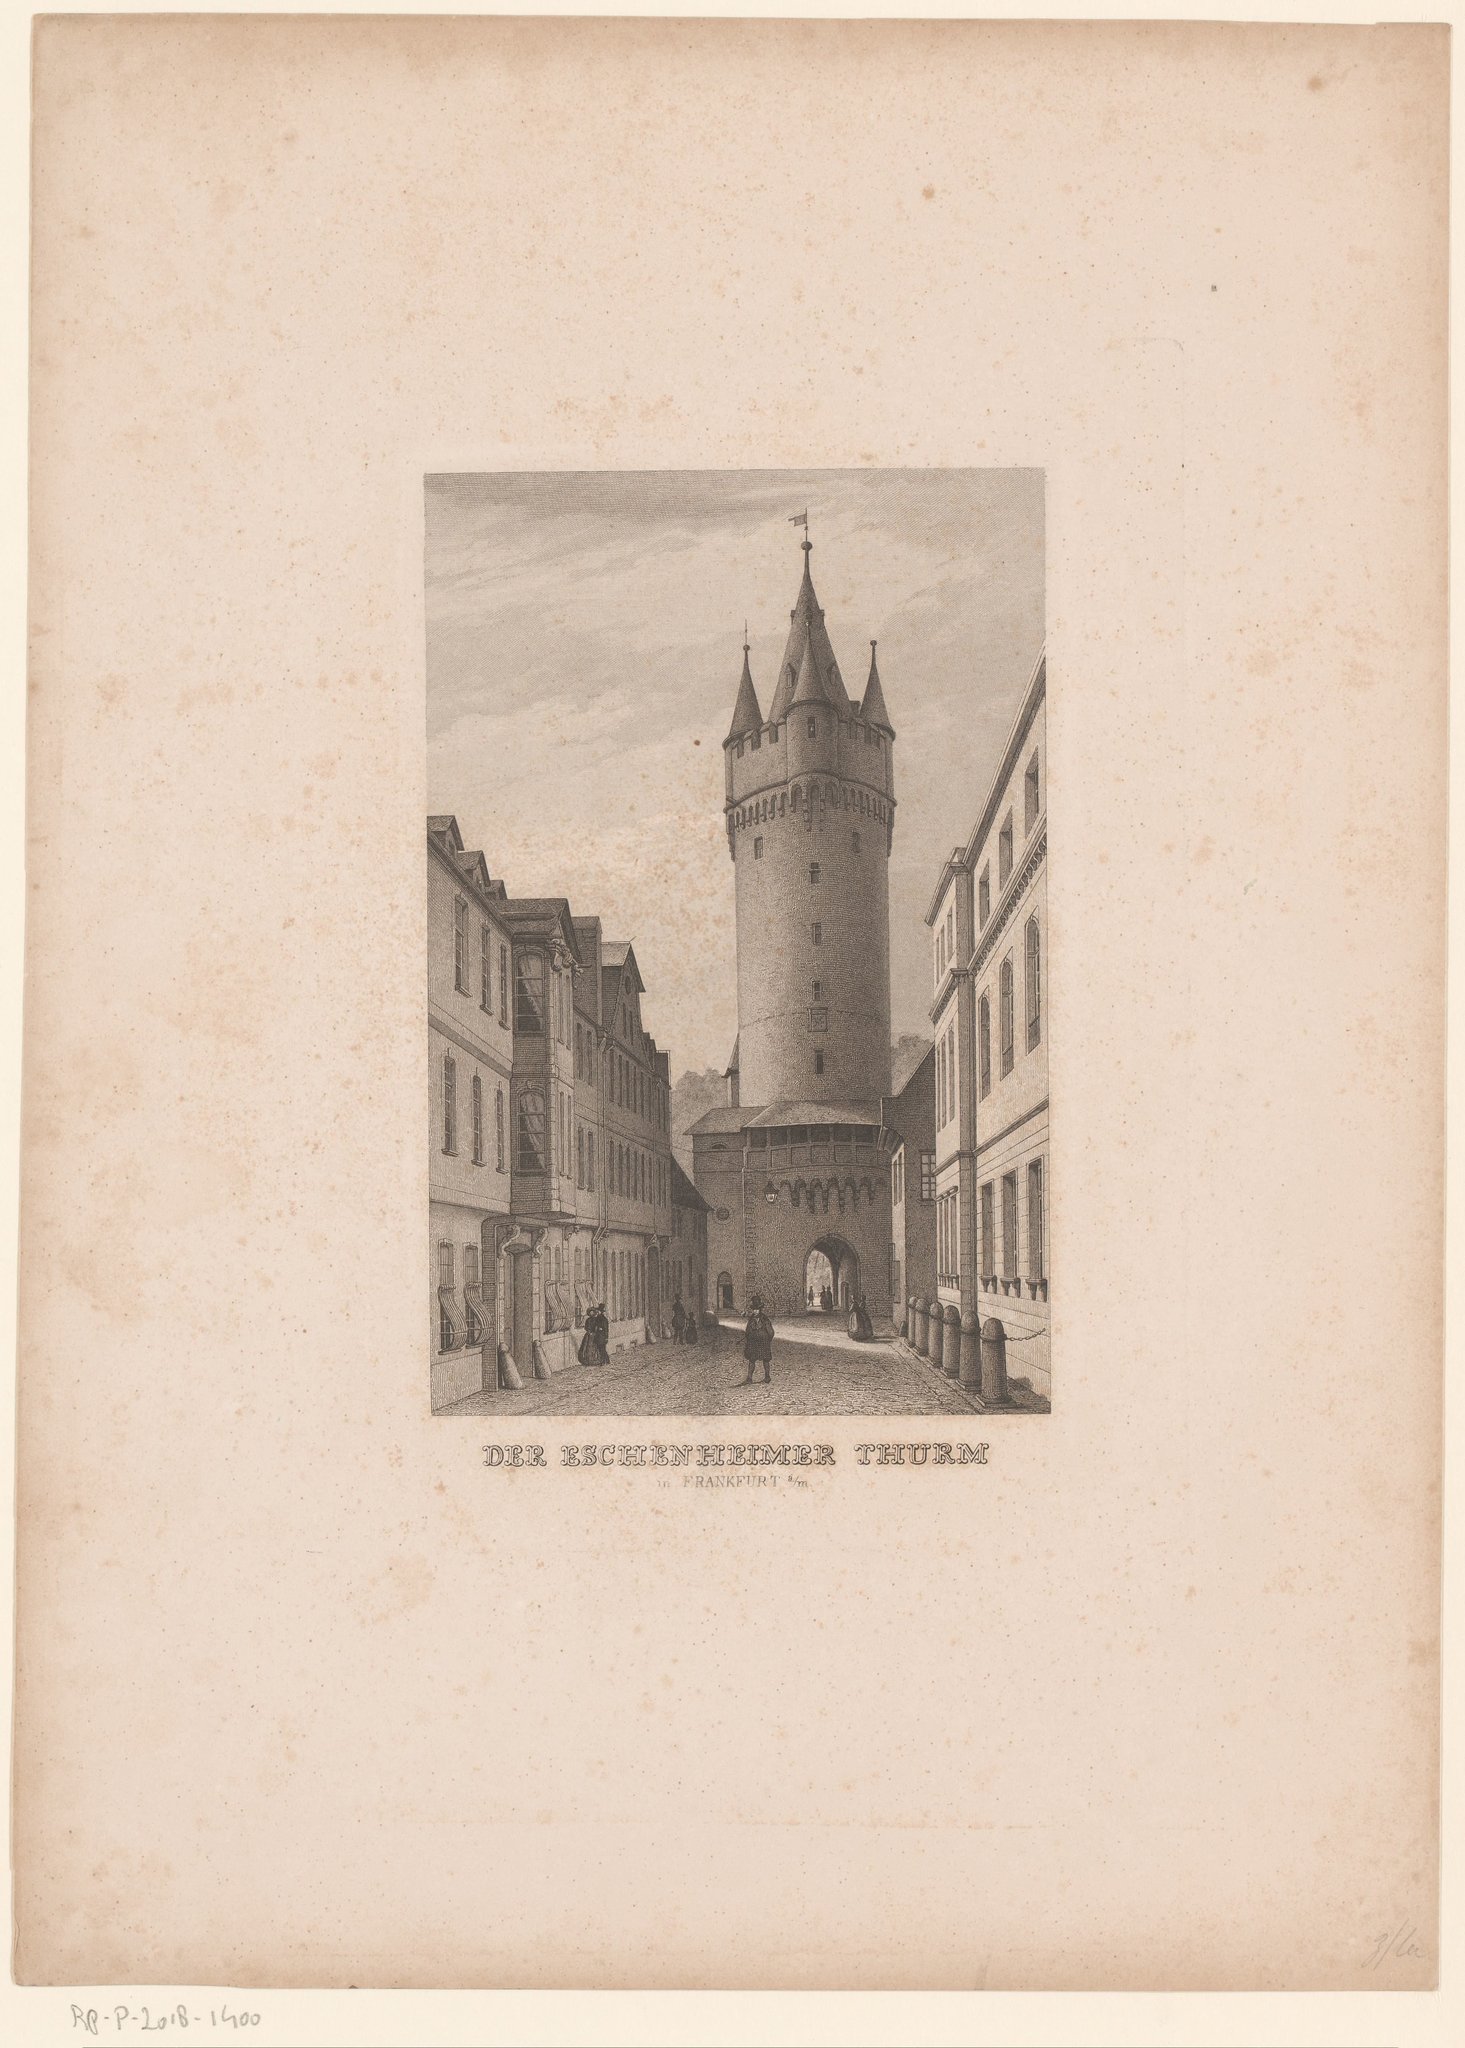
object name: print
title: Gezicht op de Eschenheimer Turm, te Frankfurt am Main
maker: Anonymous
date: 1800-1899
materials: paper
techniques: etching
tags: towers ~ fortified city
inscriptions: collector's mark: Lugt 2228